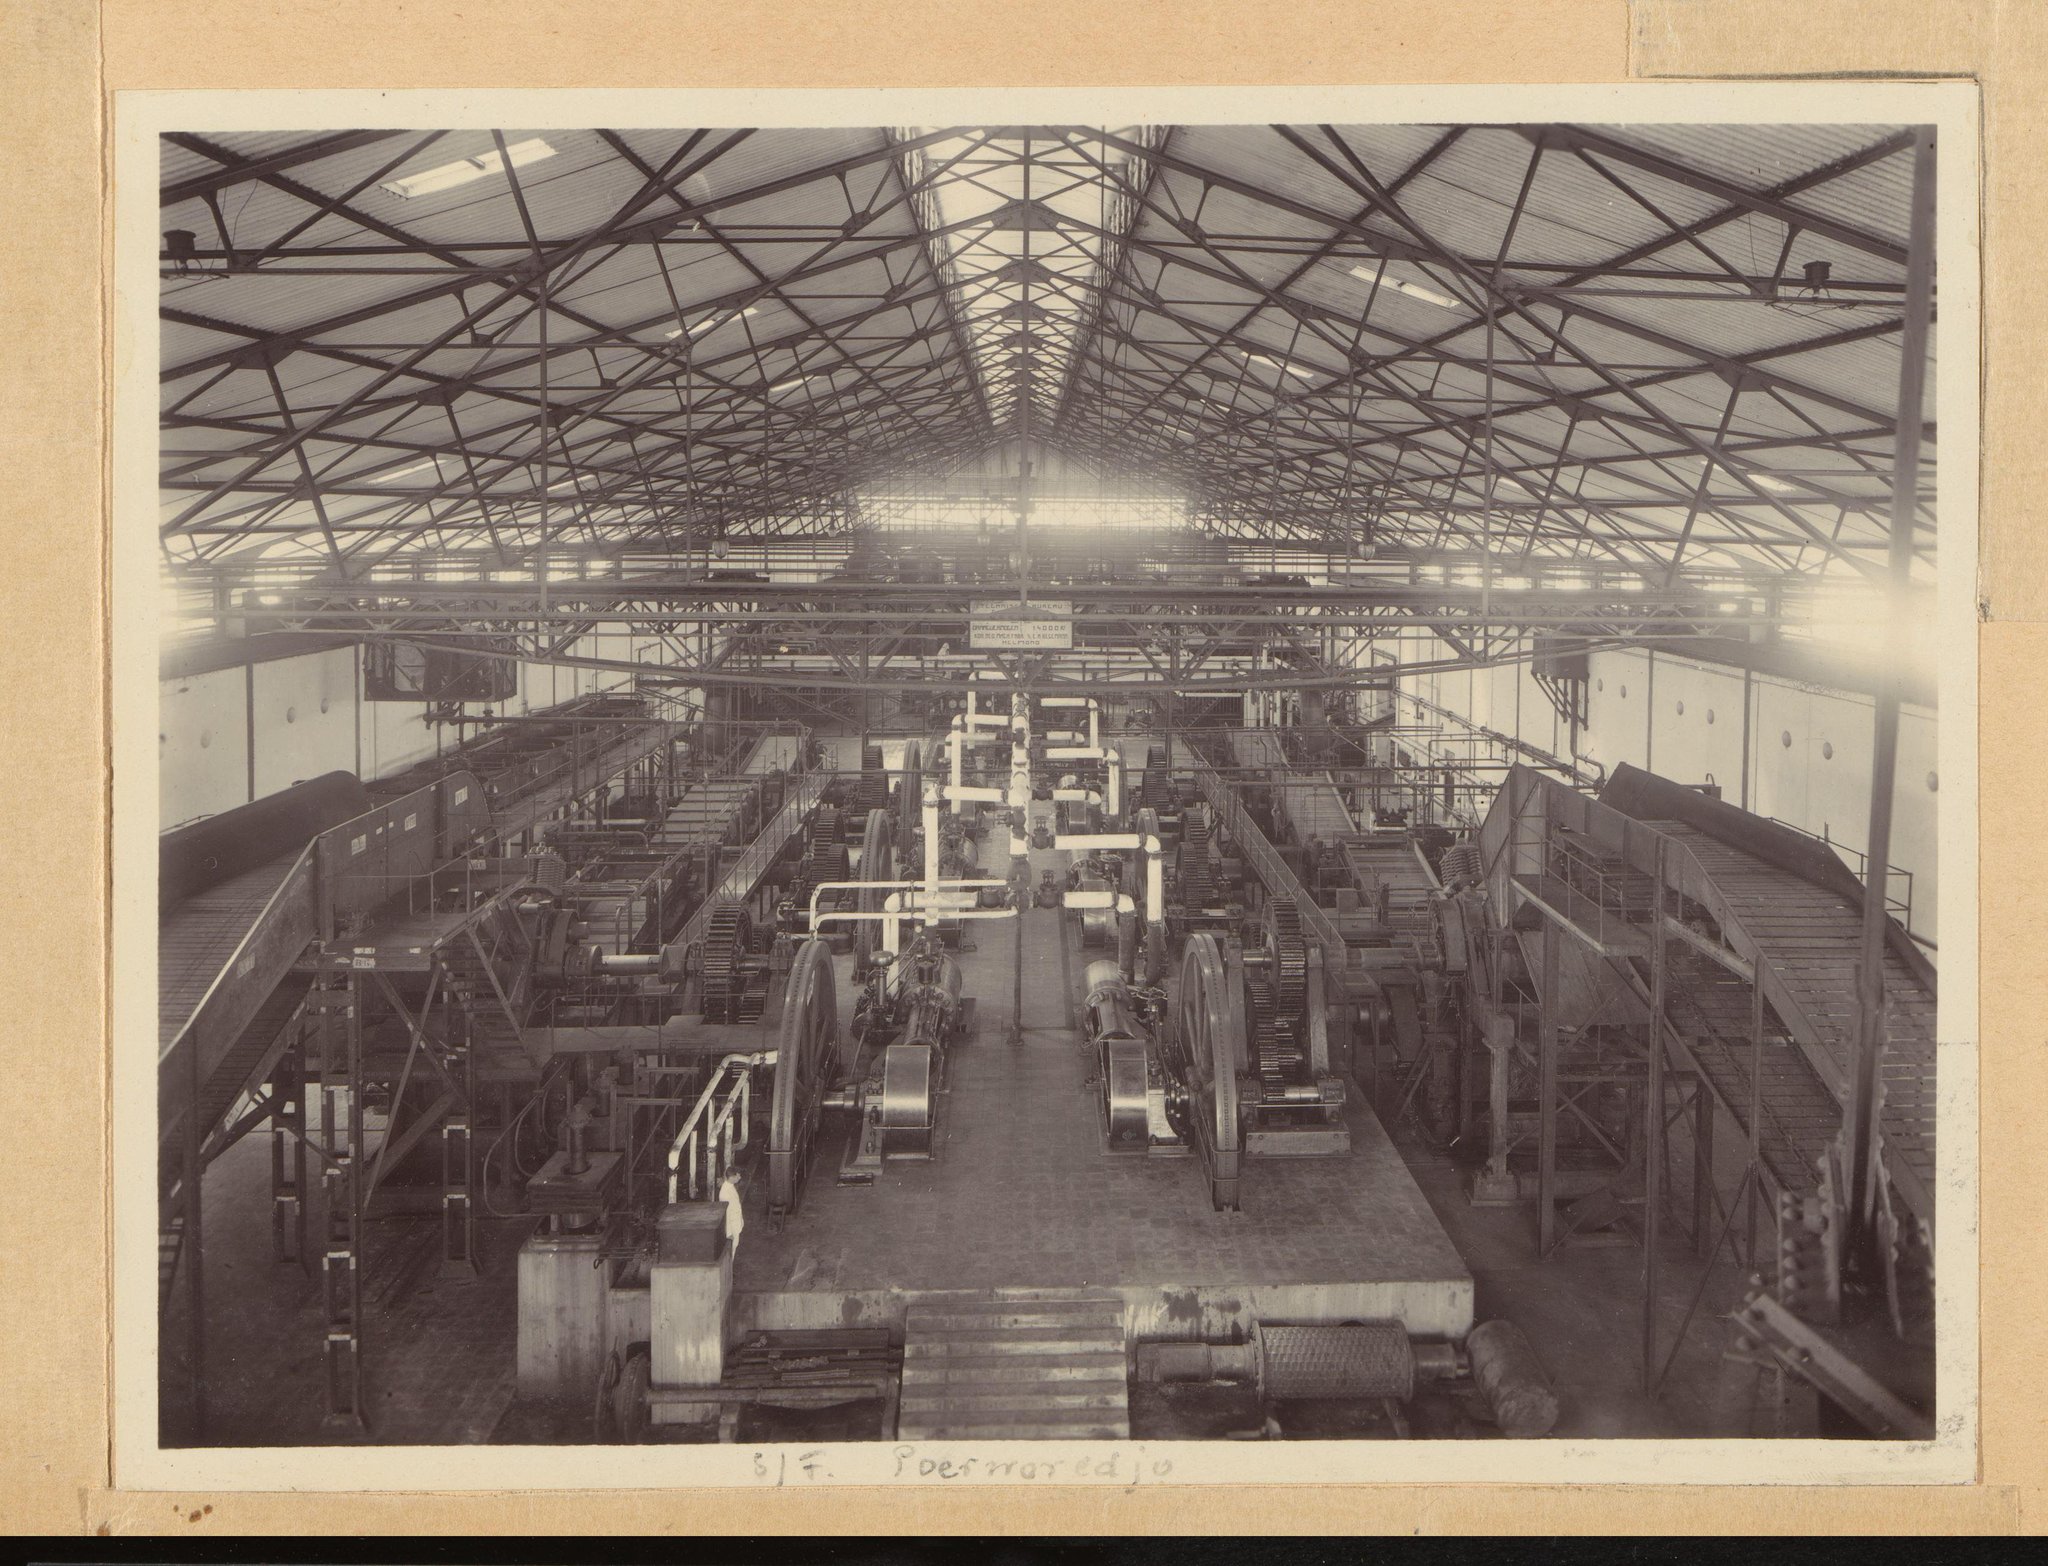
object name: photograph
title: Fabriekshal, vermoedelijk interieur van een suikerfabriek in Purworejo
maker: Anonymous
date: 1916-1918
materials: photographic support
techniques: gelatin silver print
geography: purworejo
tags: factory-interior, machine shop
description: Onderdeel van Familiealbum met foto's van een familie in de voormalige kolonie Nederlands-Indië en van een suikerfabriek in Purworejo.